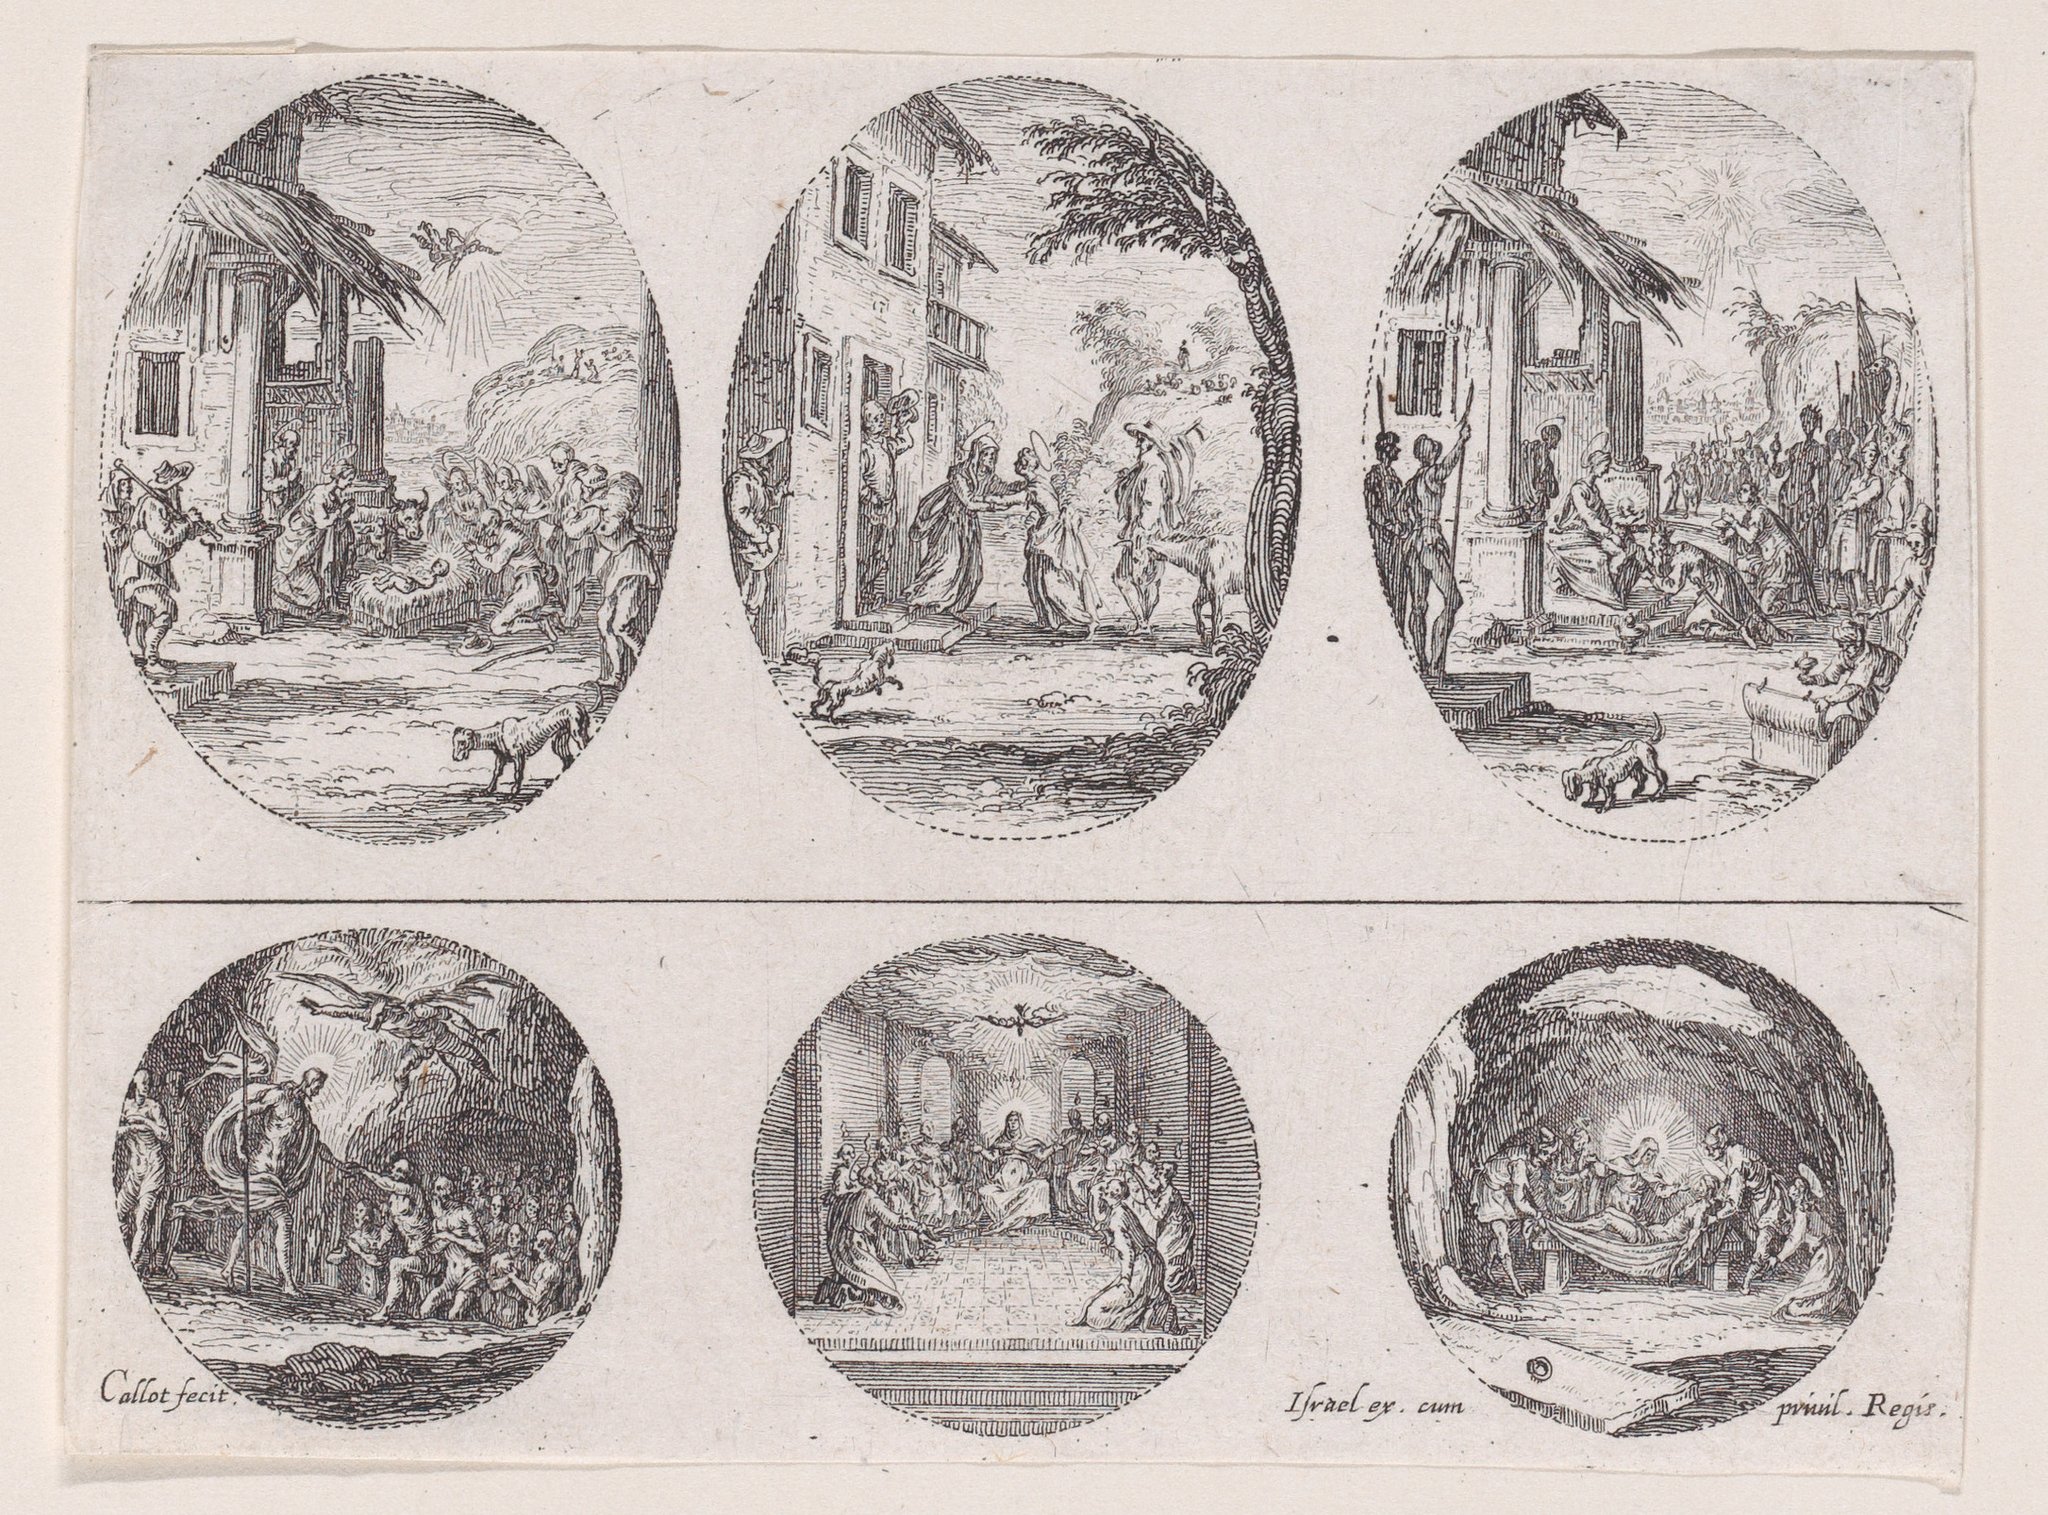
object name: print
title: Plate Containing Three Oval Medallions, from "Variae tum Passionis Christi tum vitae beatae Mariae Virginis; Les Mystères de la Passion suite appelée aussi Mystères de la Vie de Jésus et Mystères de la Vie de Jésus et de la Vie de la Ste. Vierge" (The Mysteries of the Passion, also called the Mysteries of the Life of Jesus, and the Mysteries of the Life of Jesus and of the Virgin)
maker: jacques callot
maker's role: artist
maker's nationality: french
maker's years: 1592-1635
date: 1631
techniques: engraving, etching